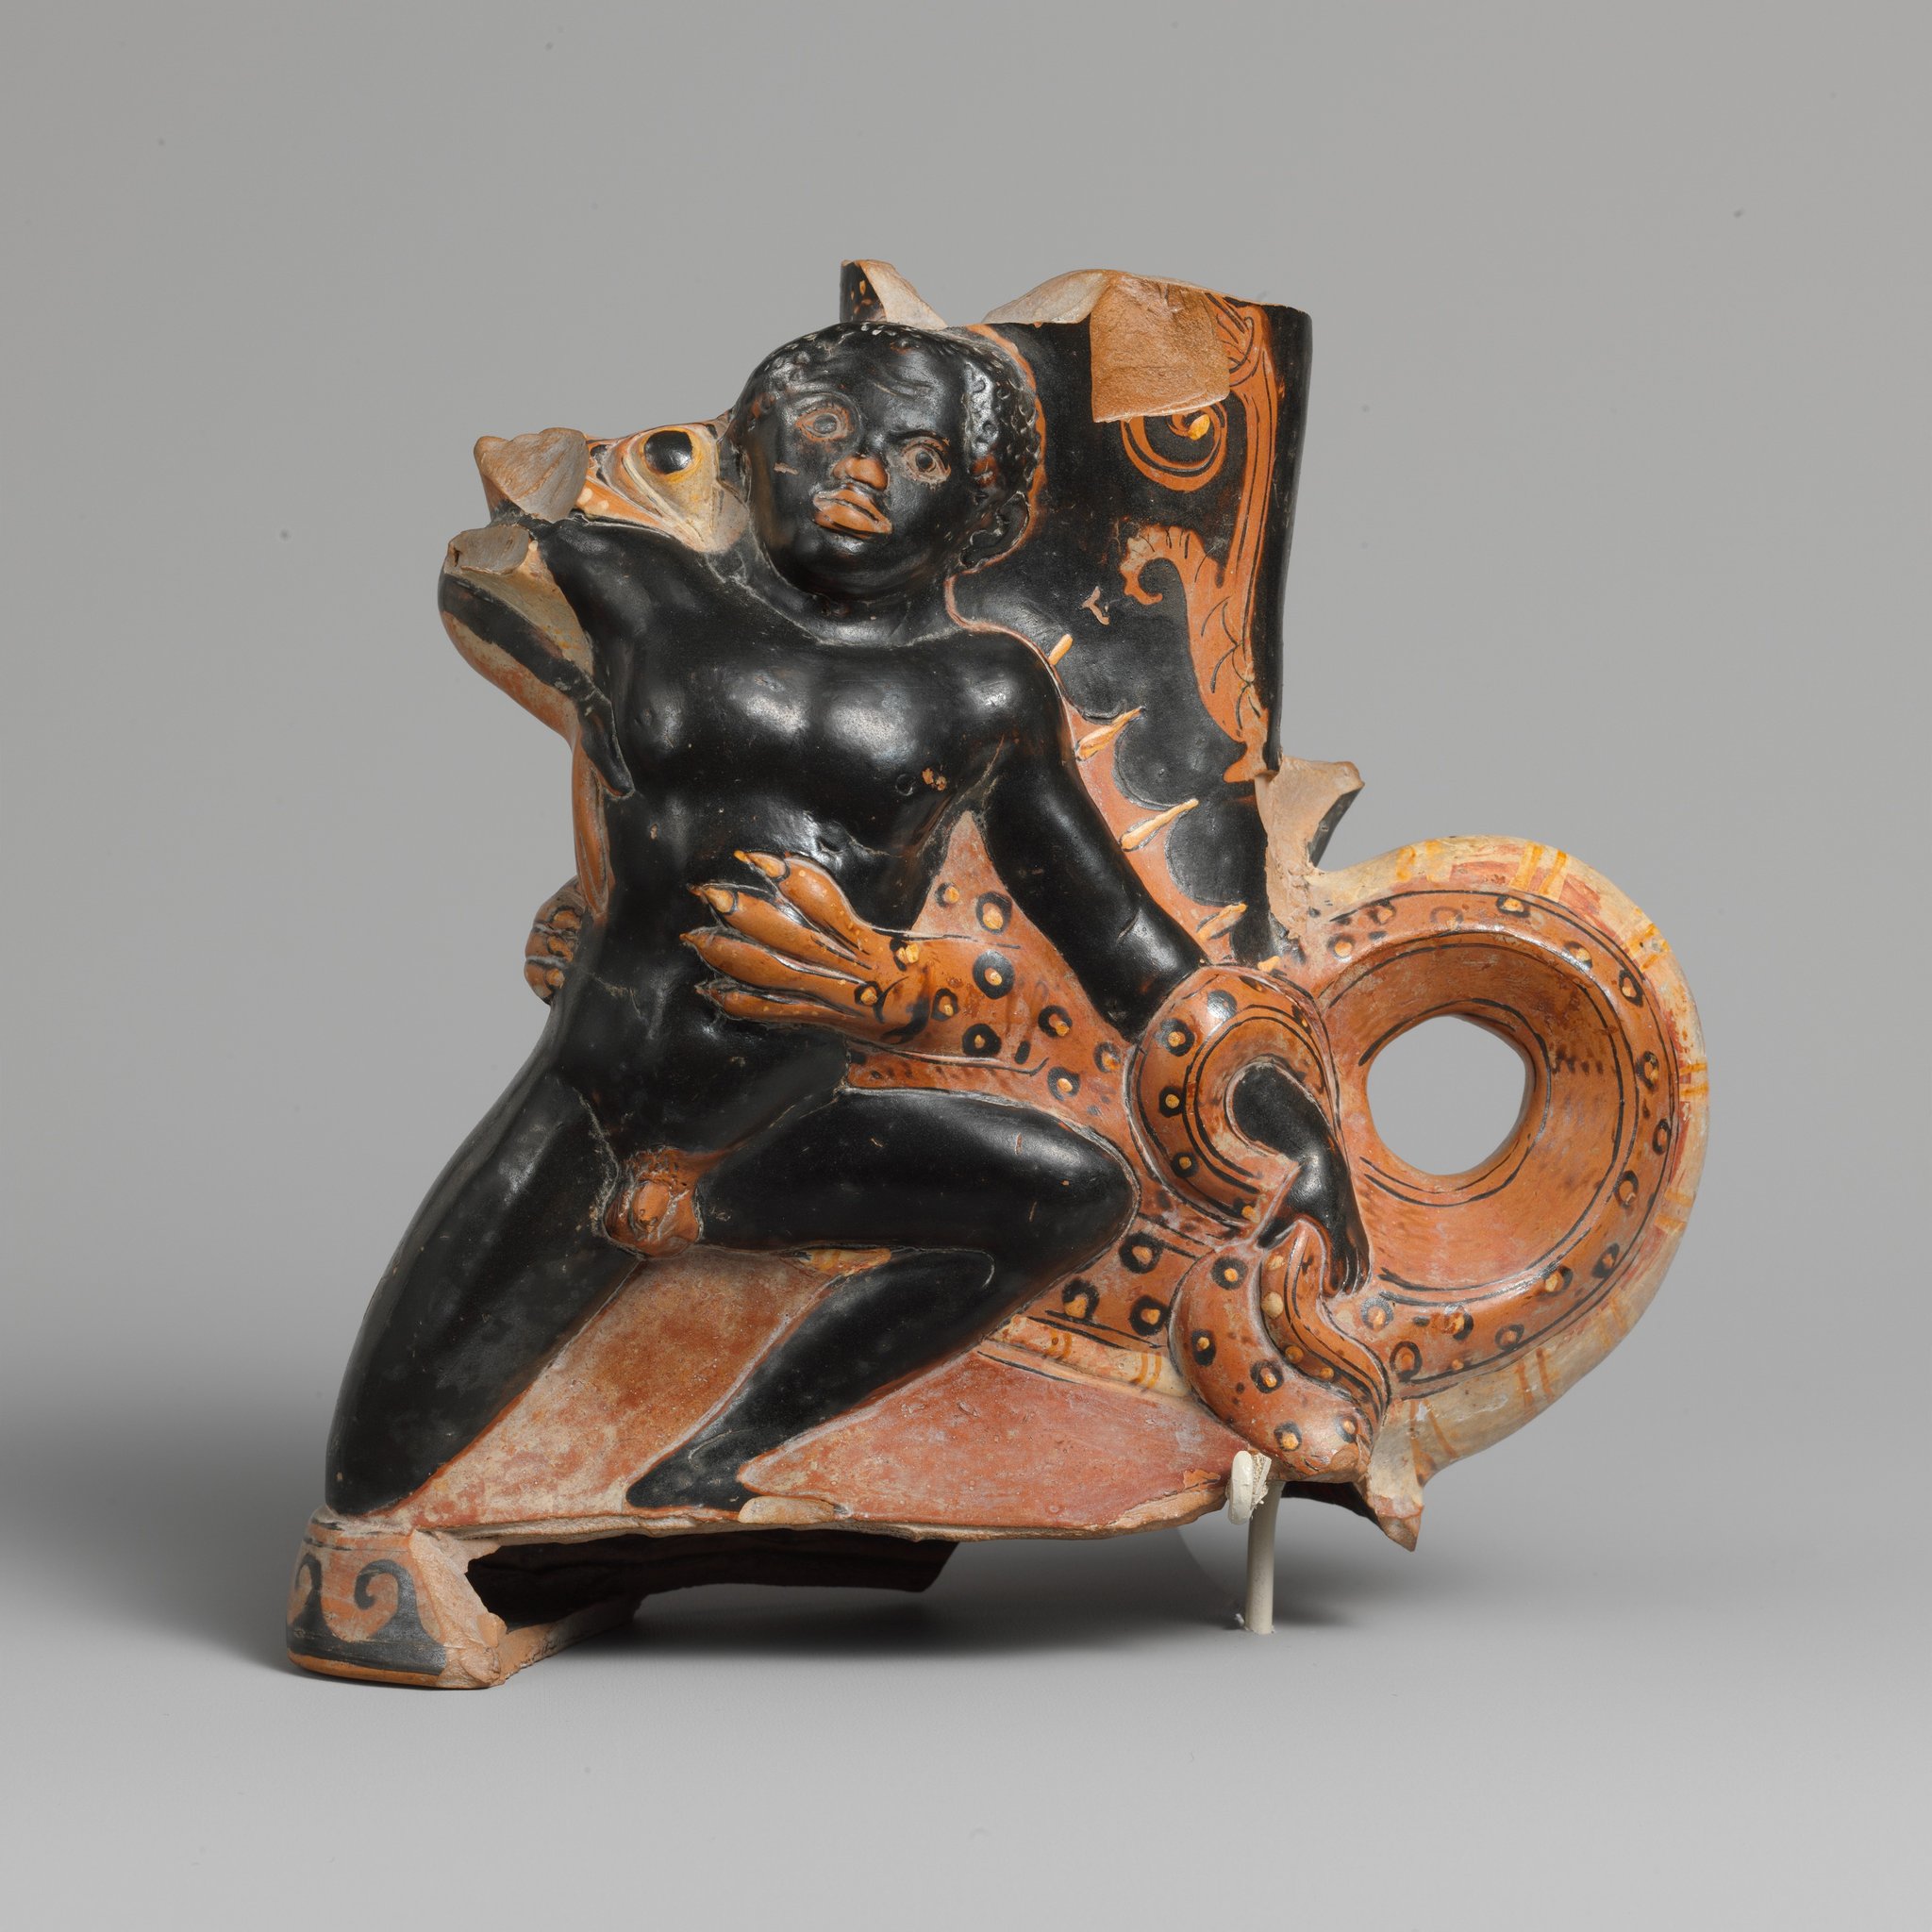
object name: rhyton in the form of a man attacked by crocodile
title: Terracotta rhyton (vase for libations or drinking)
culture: greek, south italian, apulian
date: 350-300 BCE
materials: terracotta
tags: male nudes,crocodiles